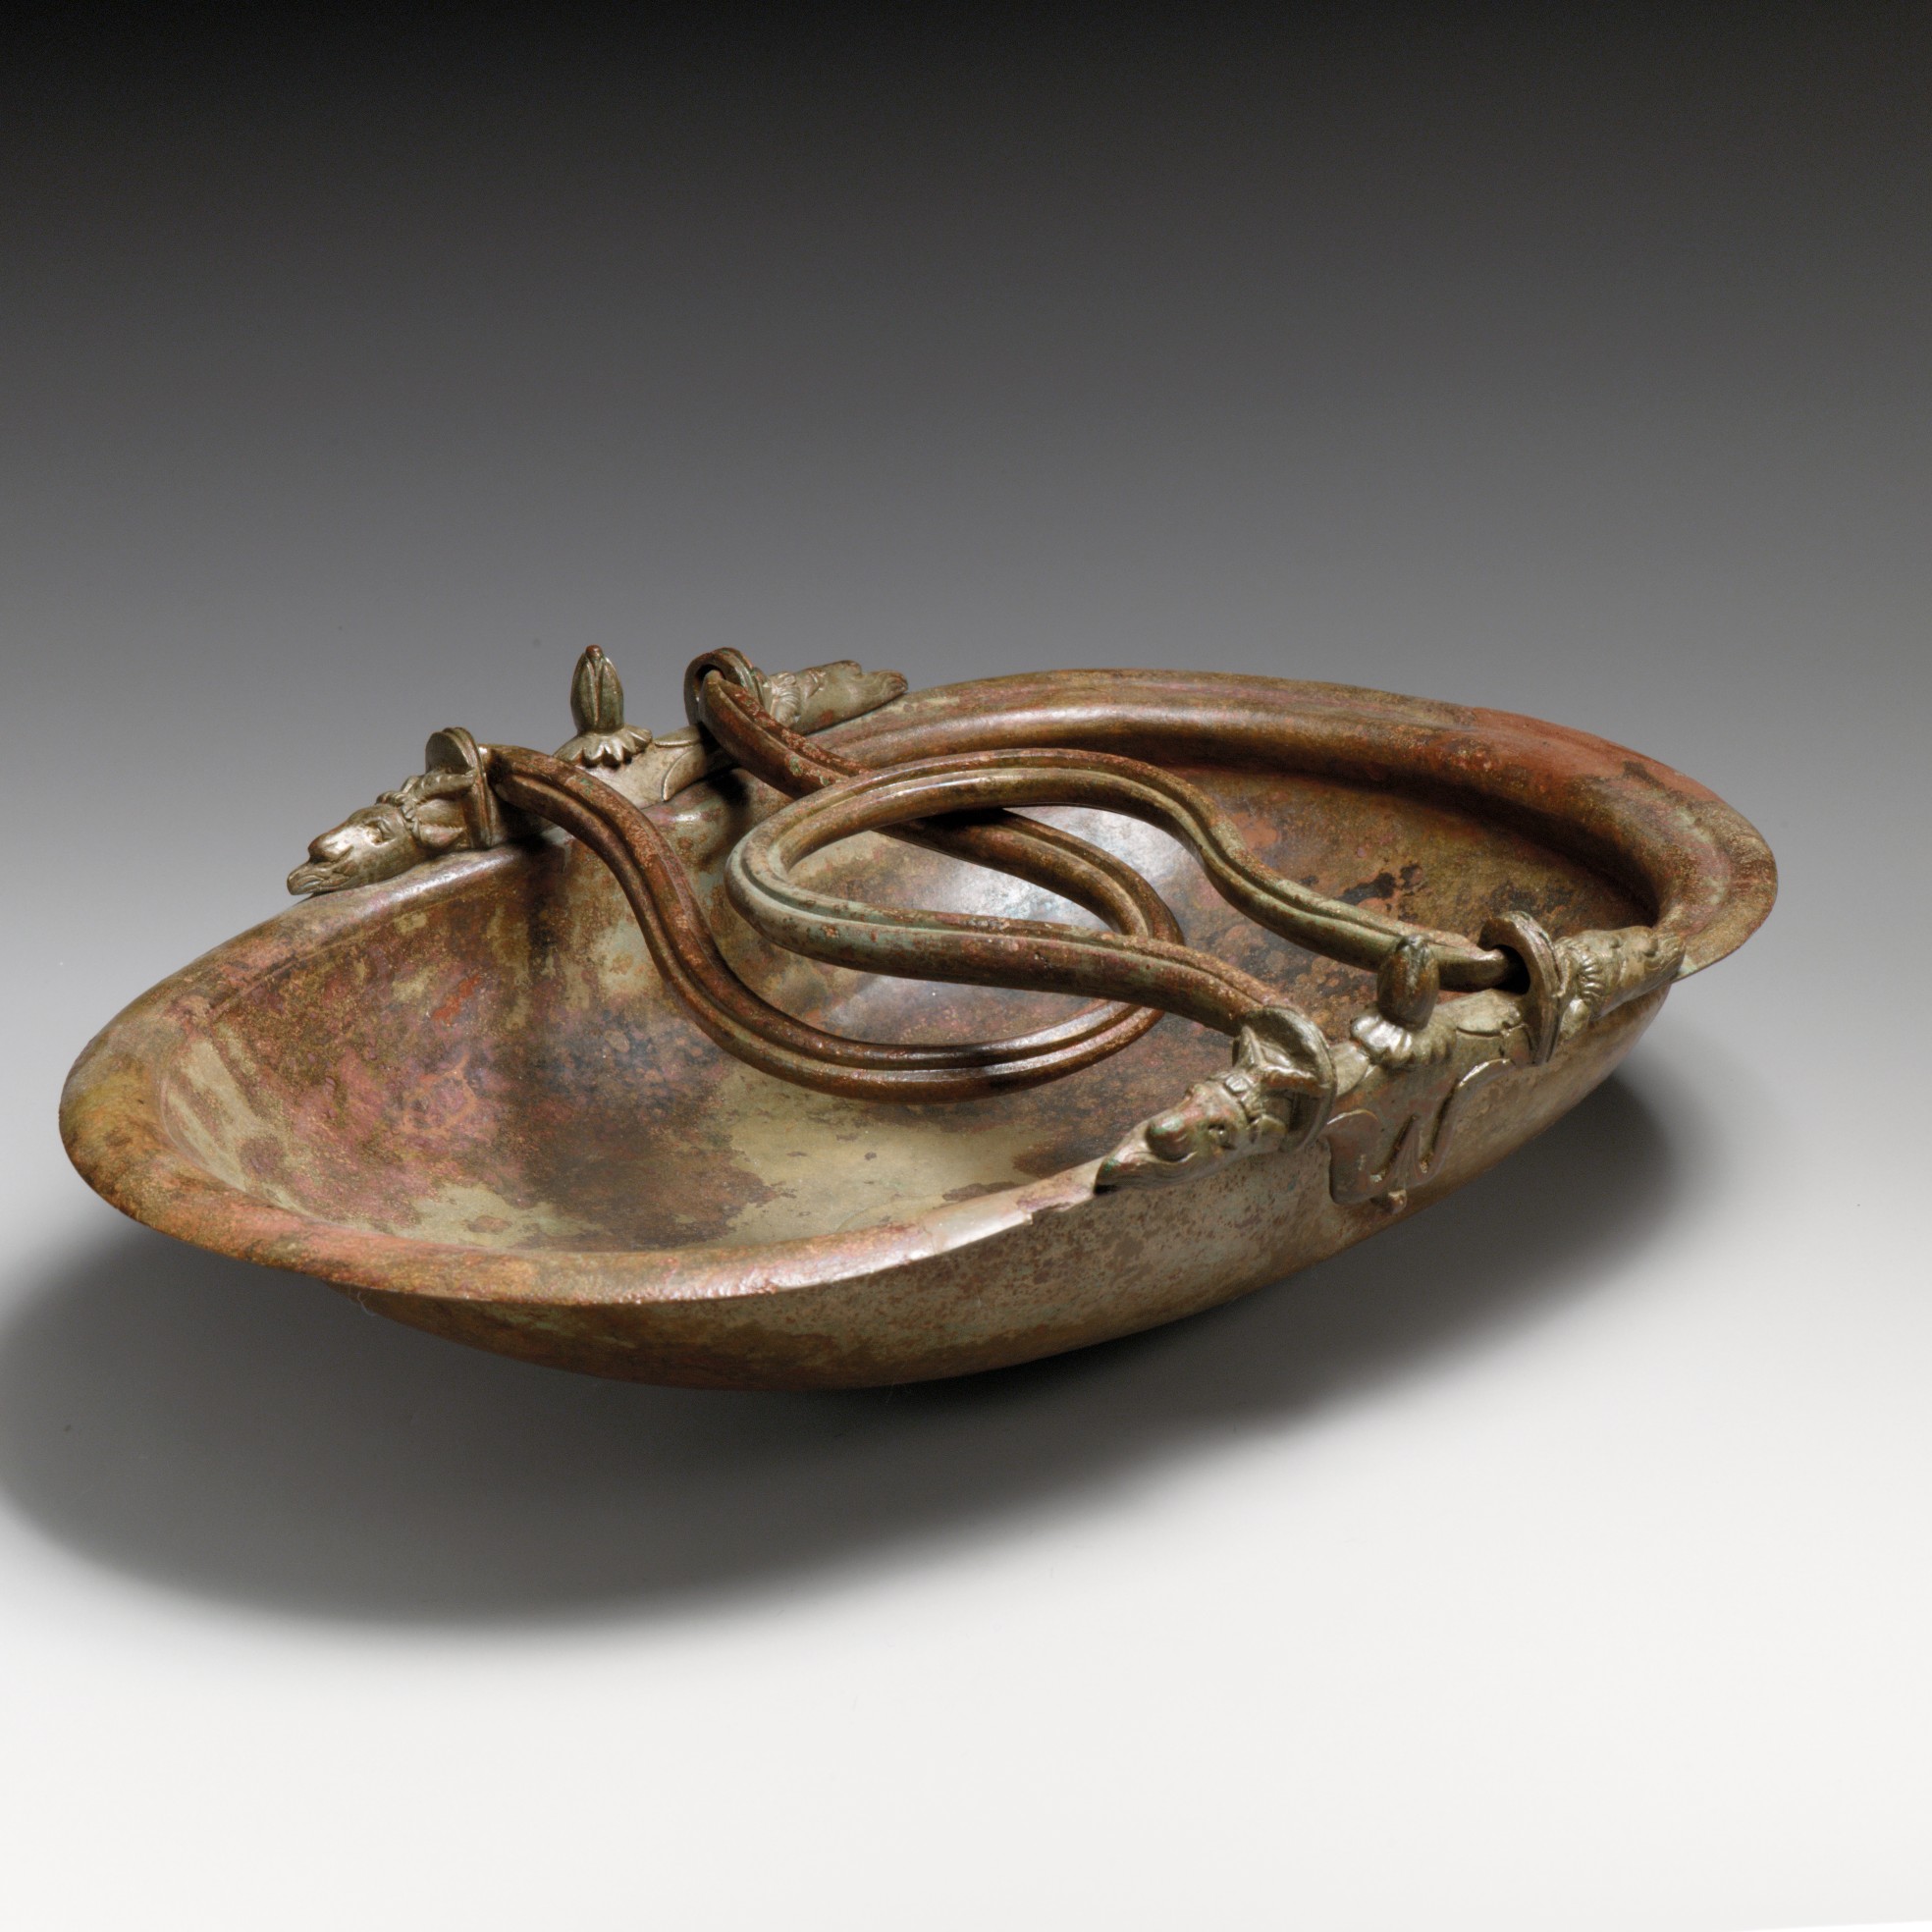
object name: basket vase with swinging handle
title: Bronze basket vase with swinging handles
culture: roman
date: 100-1 BCE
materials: bronze